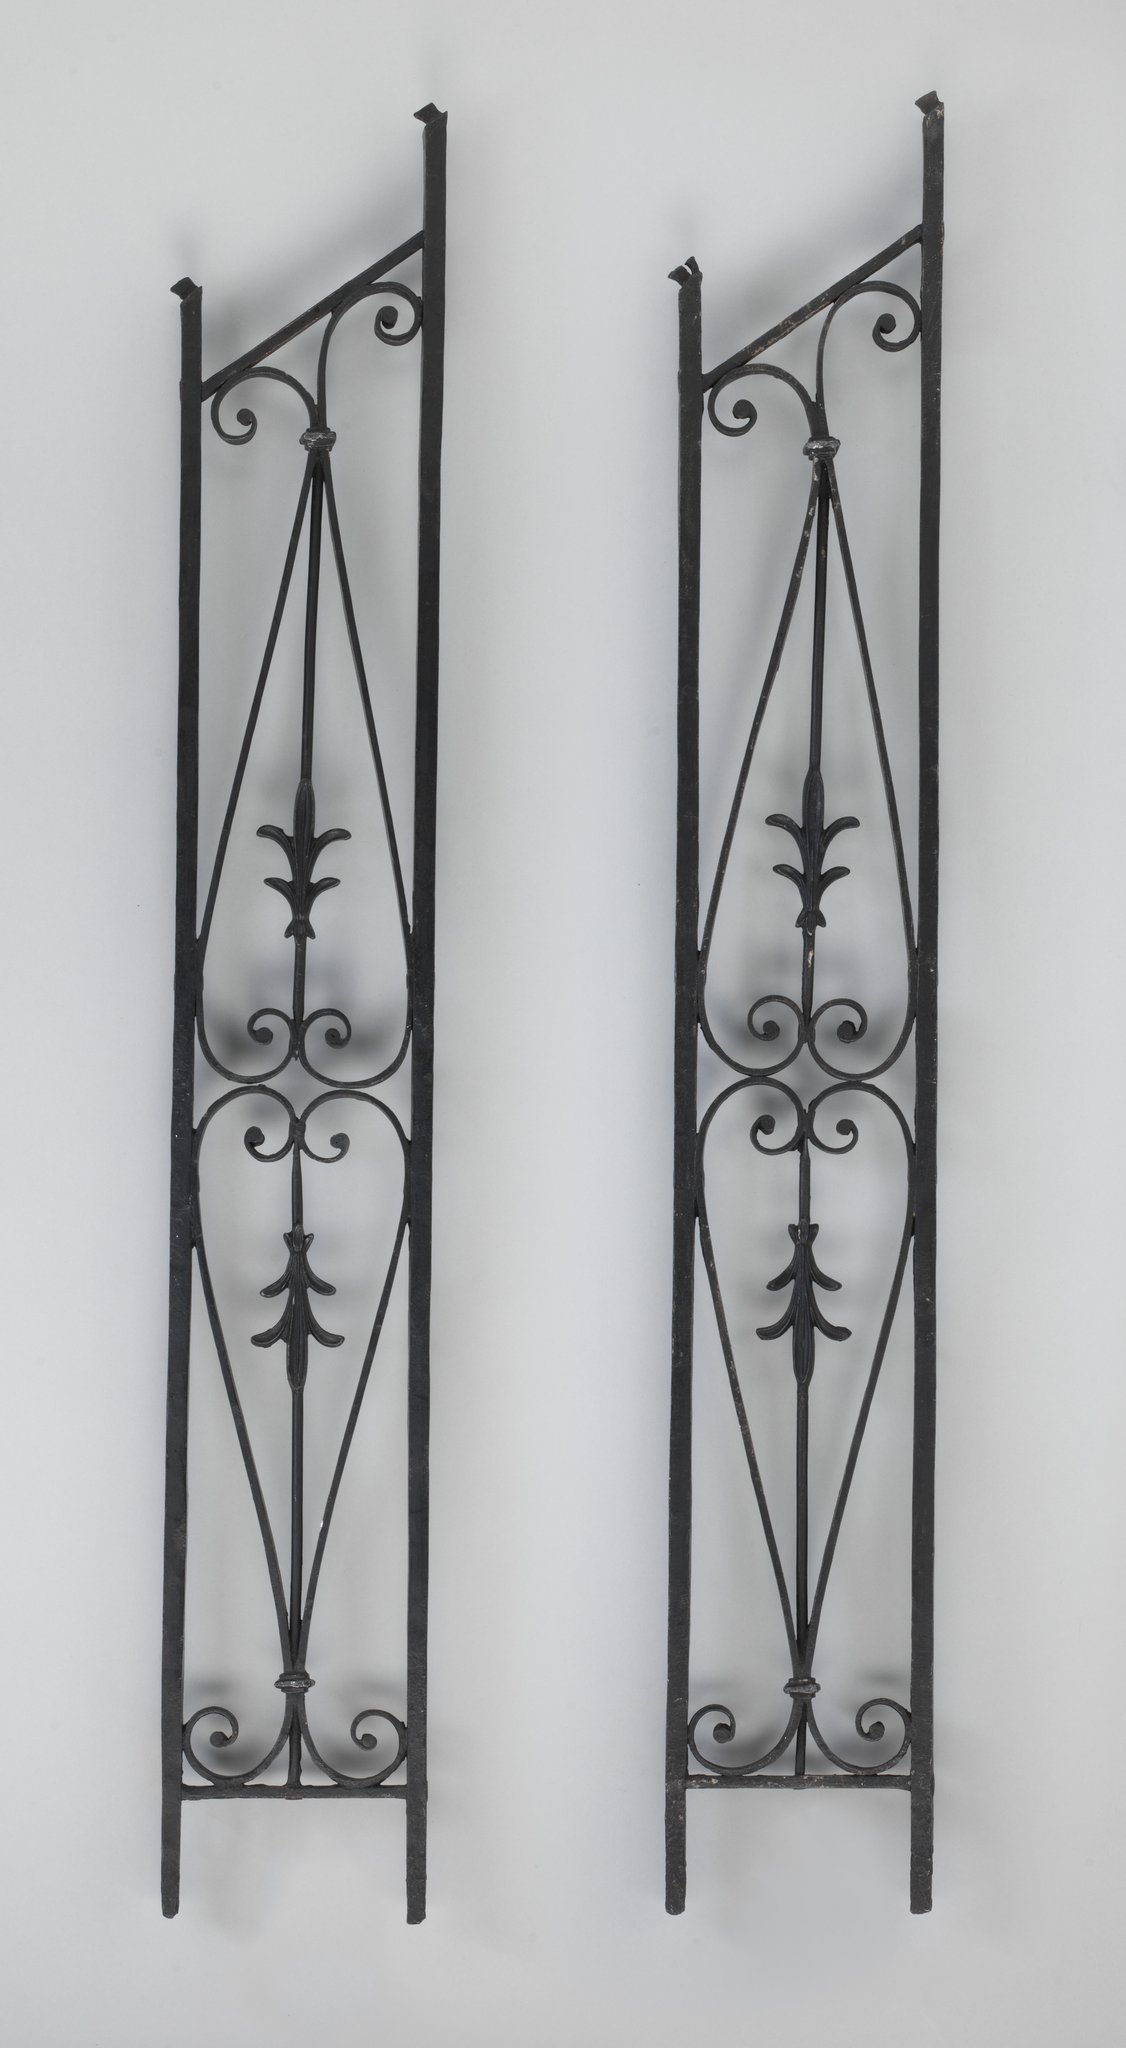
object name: baluster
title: Iron baluster (one of a pair)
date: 1780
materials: lead, iron